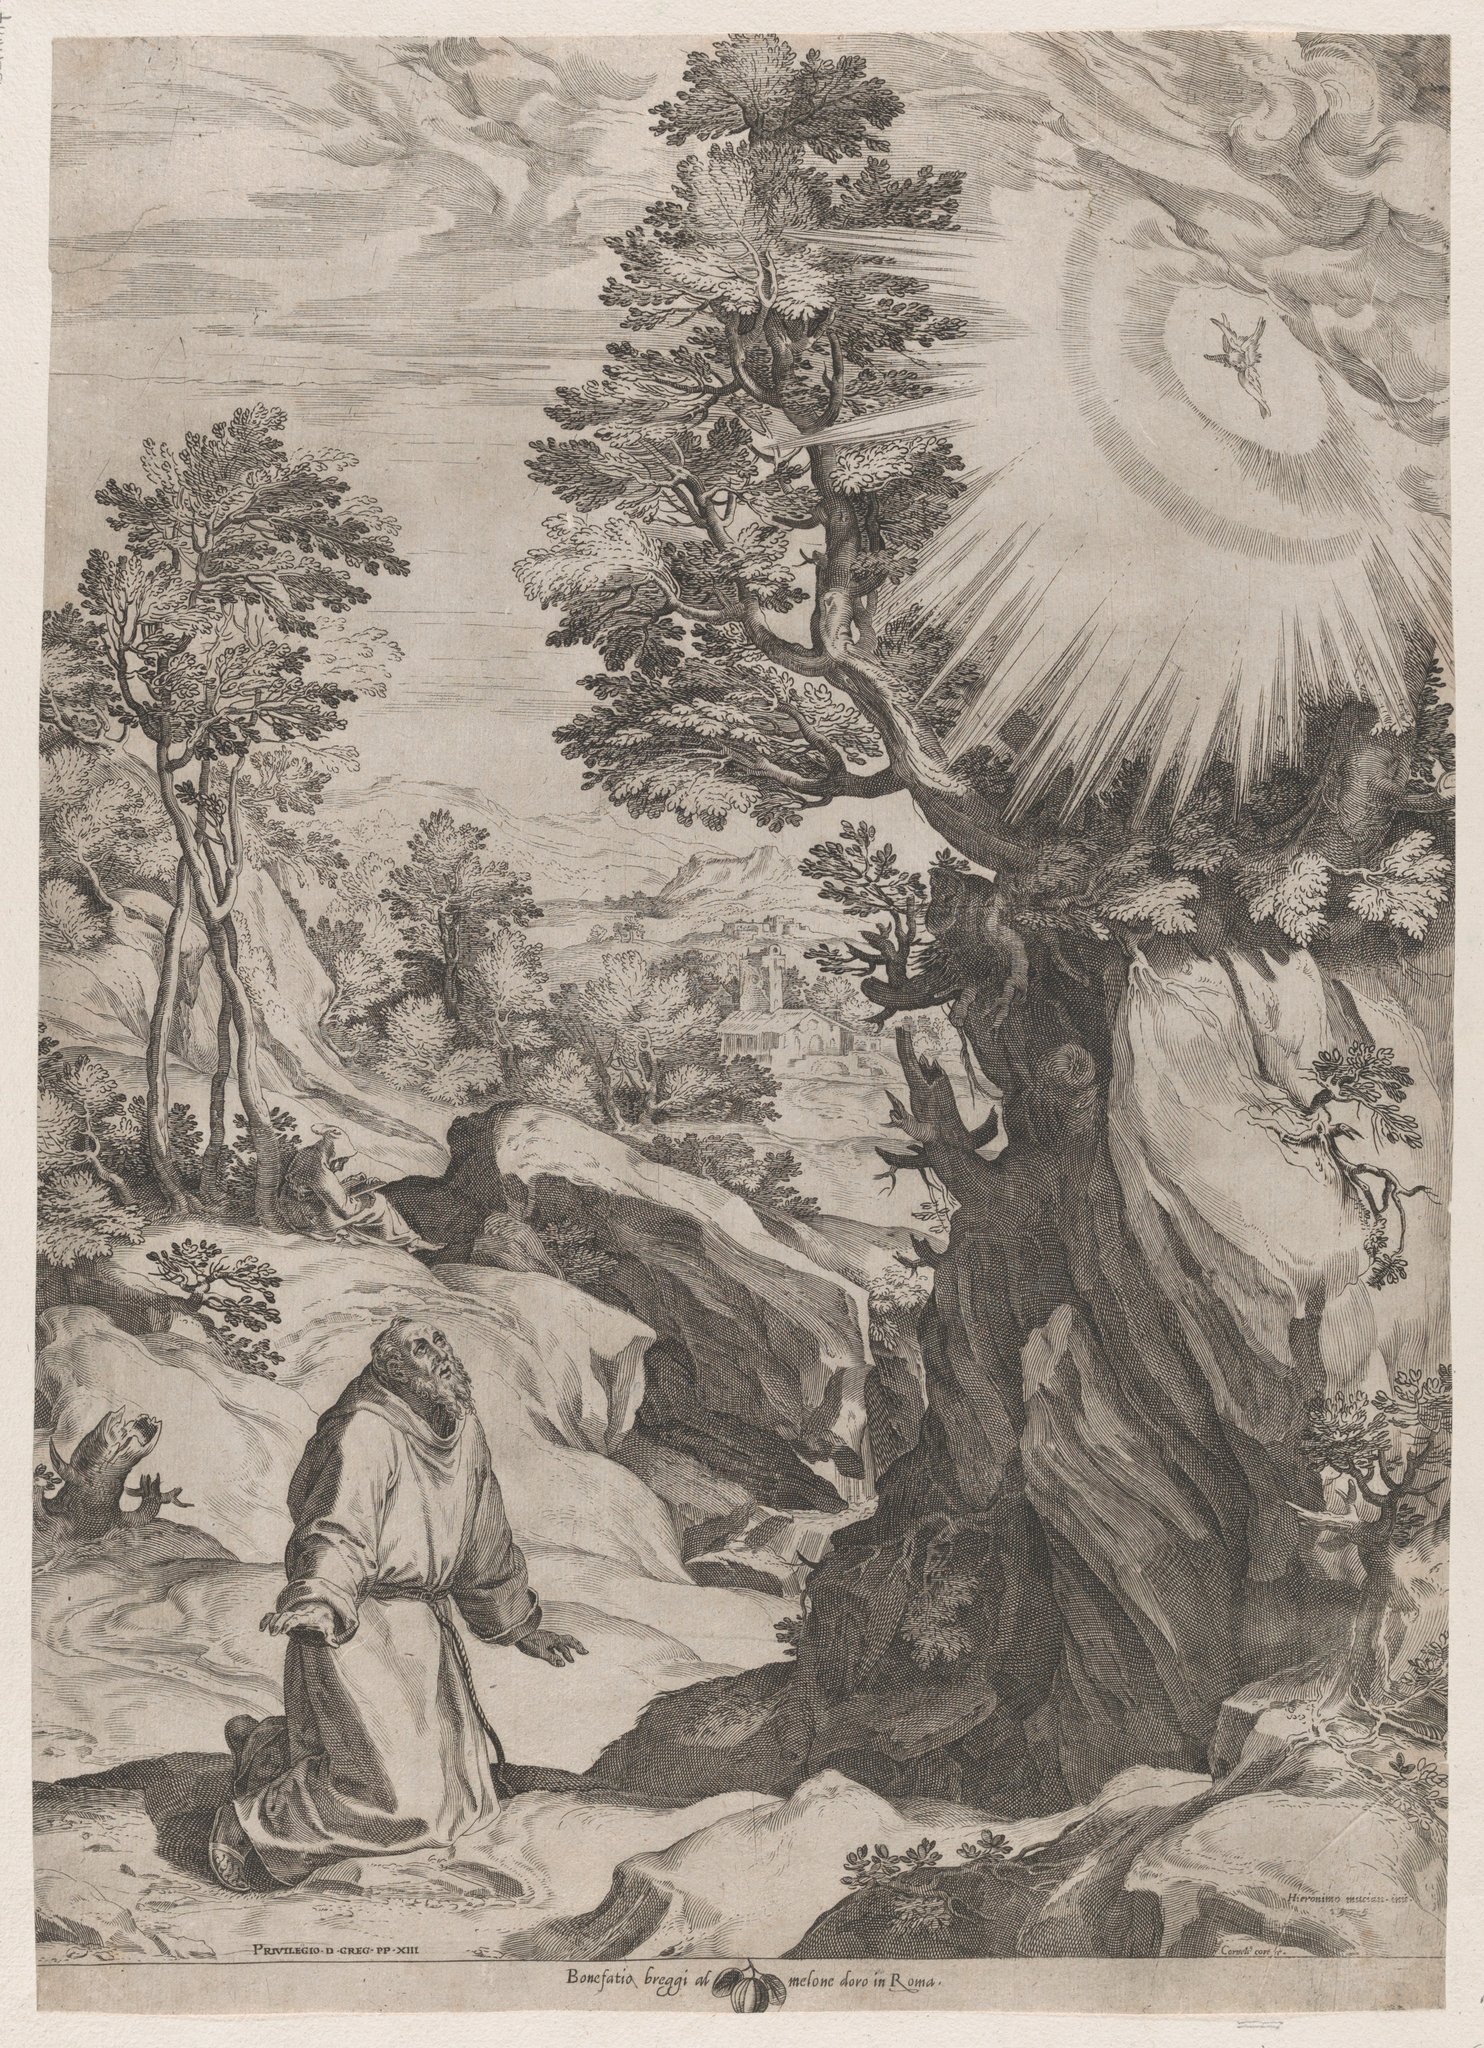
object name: print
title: St Francis Penitent in the Wilderness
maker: cornelis cort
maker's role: artist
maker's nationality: netherlandish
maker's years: 1533-1578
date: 1575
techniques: engraving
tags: saint francis